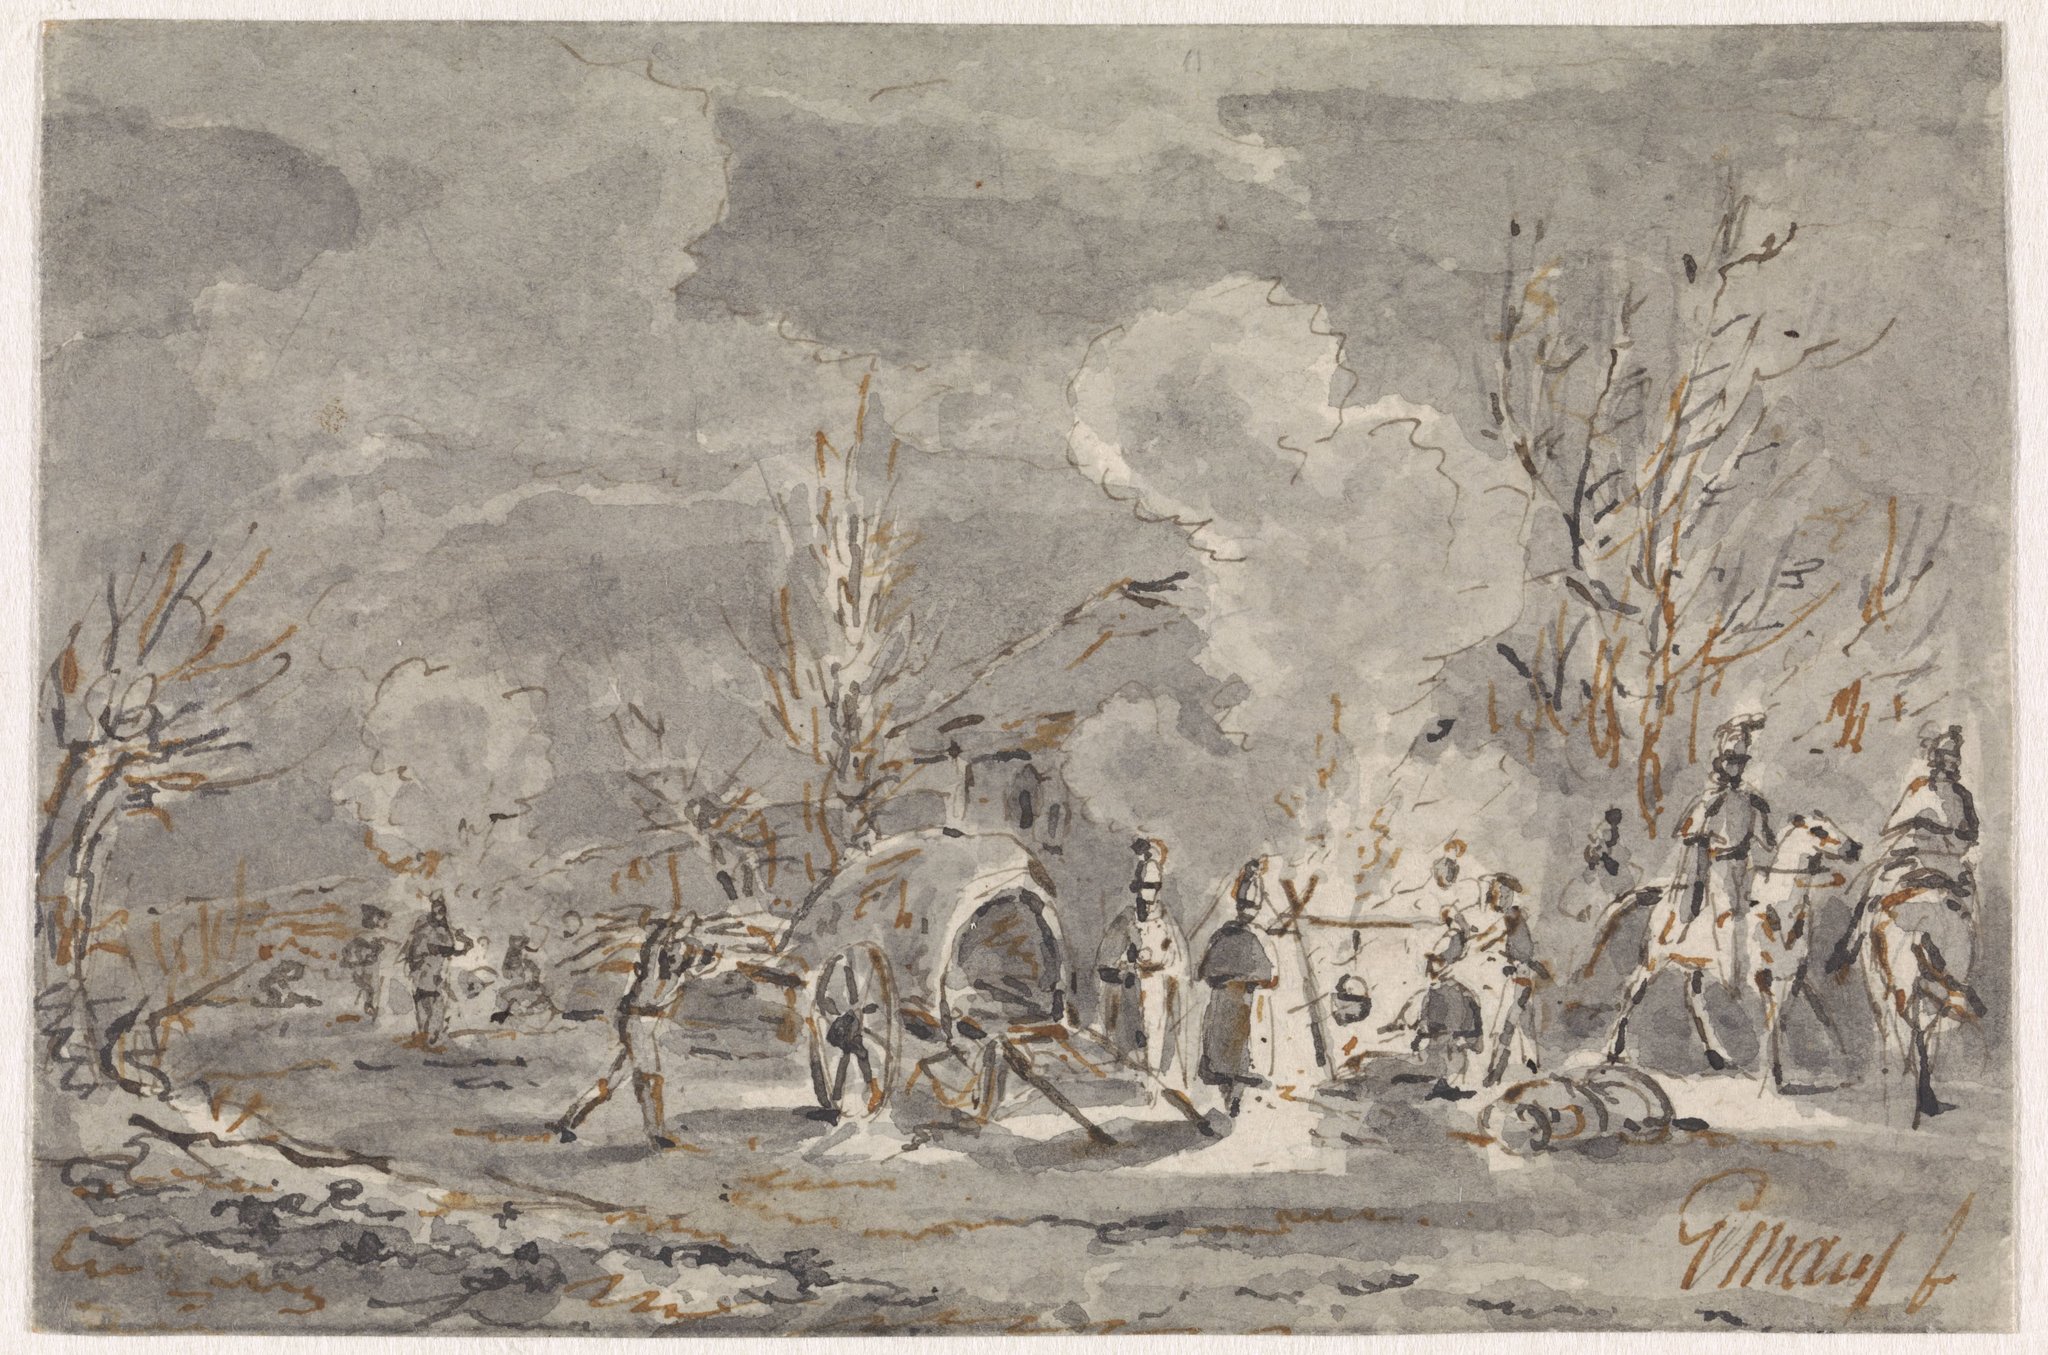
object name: drawing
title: Legerplaats met soldaten rond kampvuur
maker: gerardus emaus de micault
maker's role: draughtsman, print maker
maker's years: 1798-1863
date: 1799-1863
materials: ink, paper, pencil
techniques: brush, pen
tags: (military) camp with tents